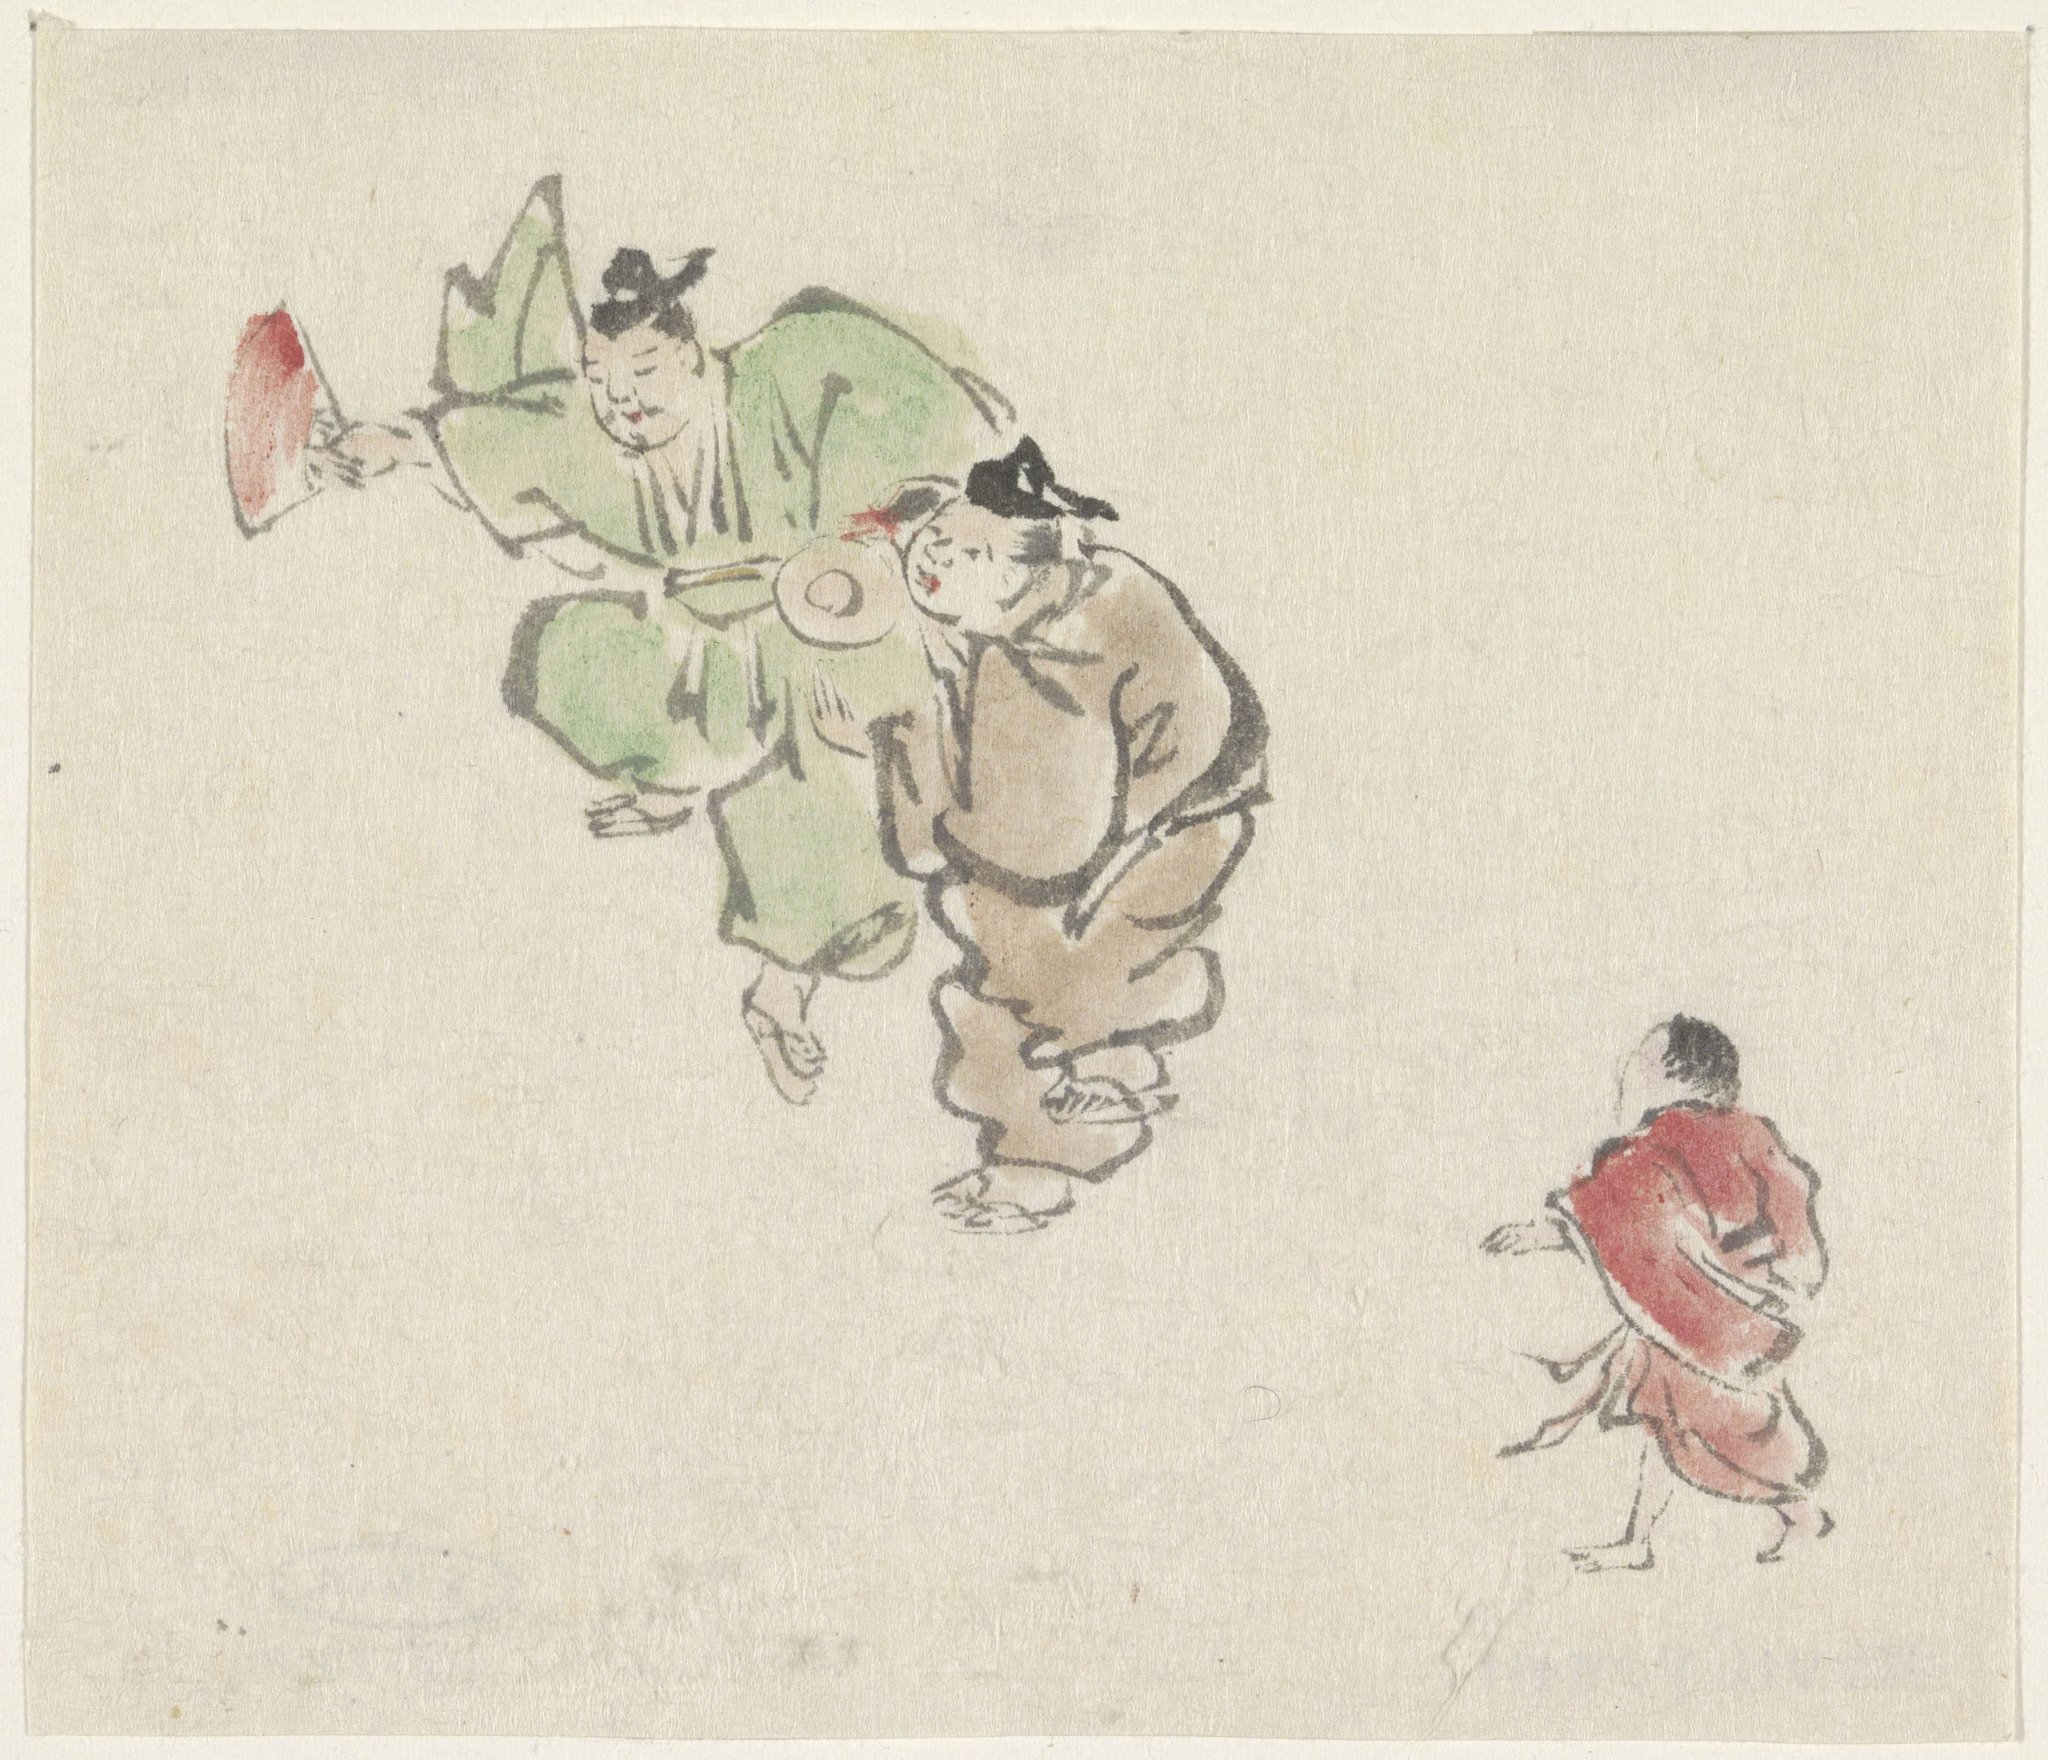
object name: watercolor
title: Twee dansers en een kind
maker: utagawa kuniyoshi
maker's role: draughtsman, print maker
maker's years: 1798-1861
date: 1808-1861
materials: paper, watercolor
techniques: brush